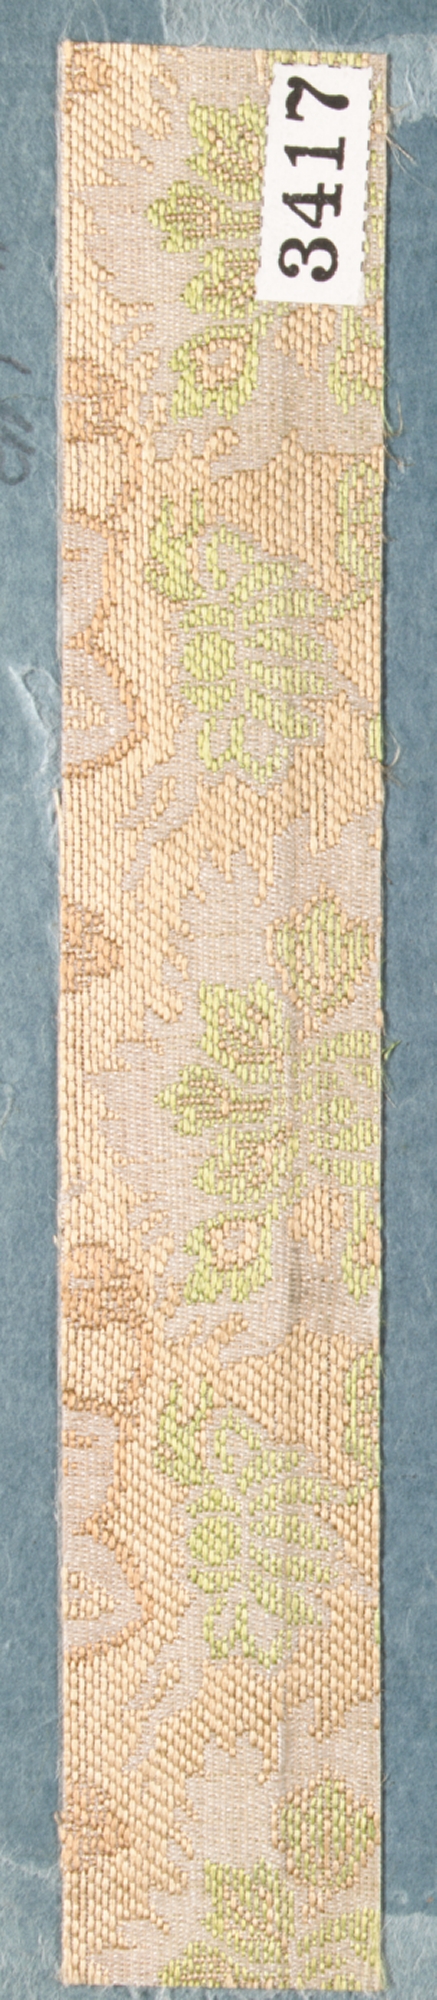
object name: textile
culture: japanese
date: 1801-1900